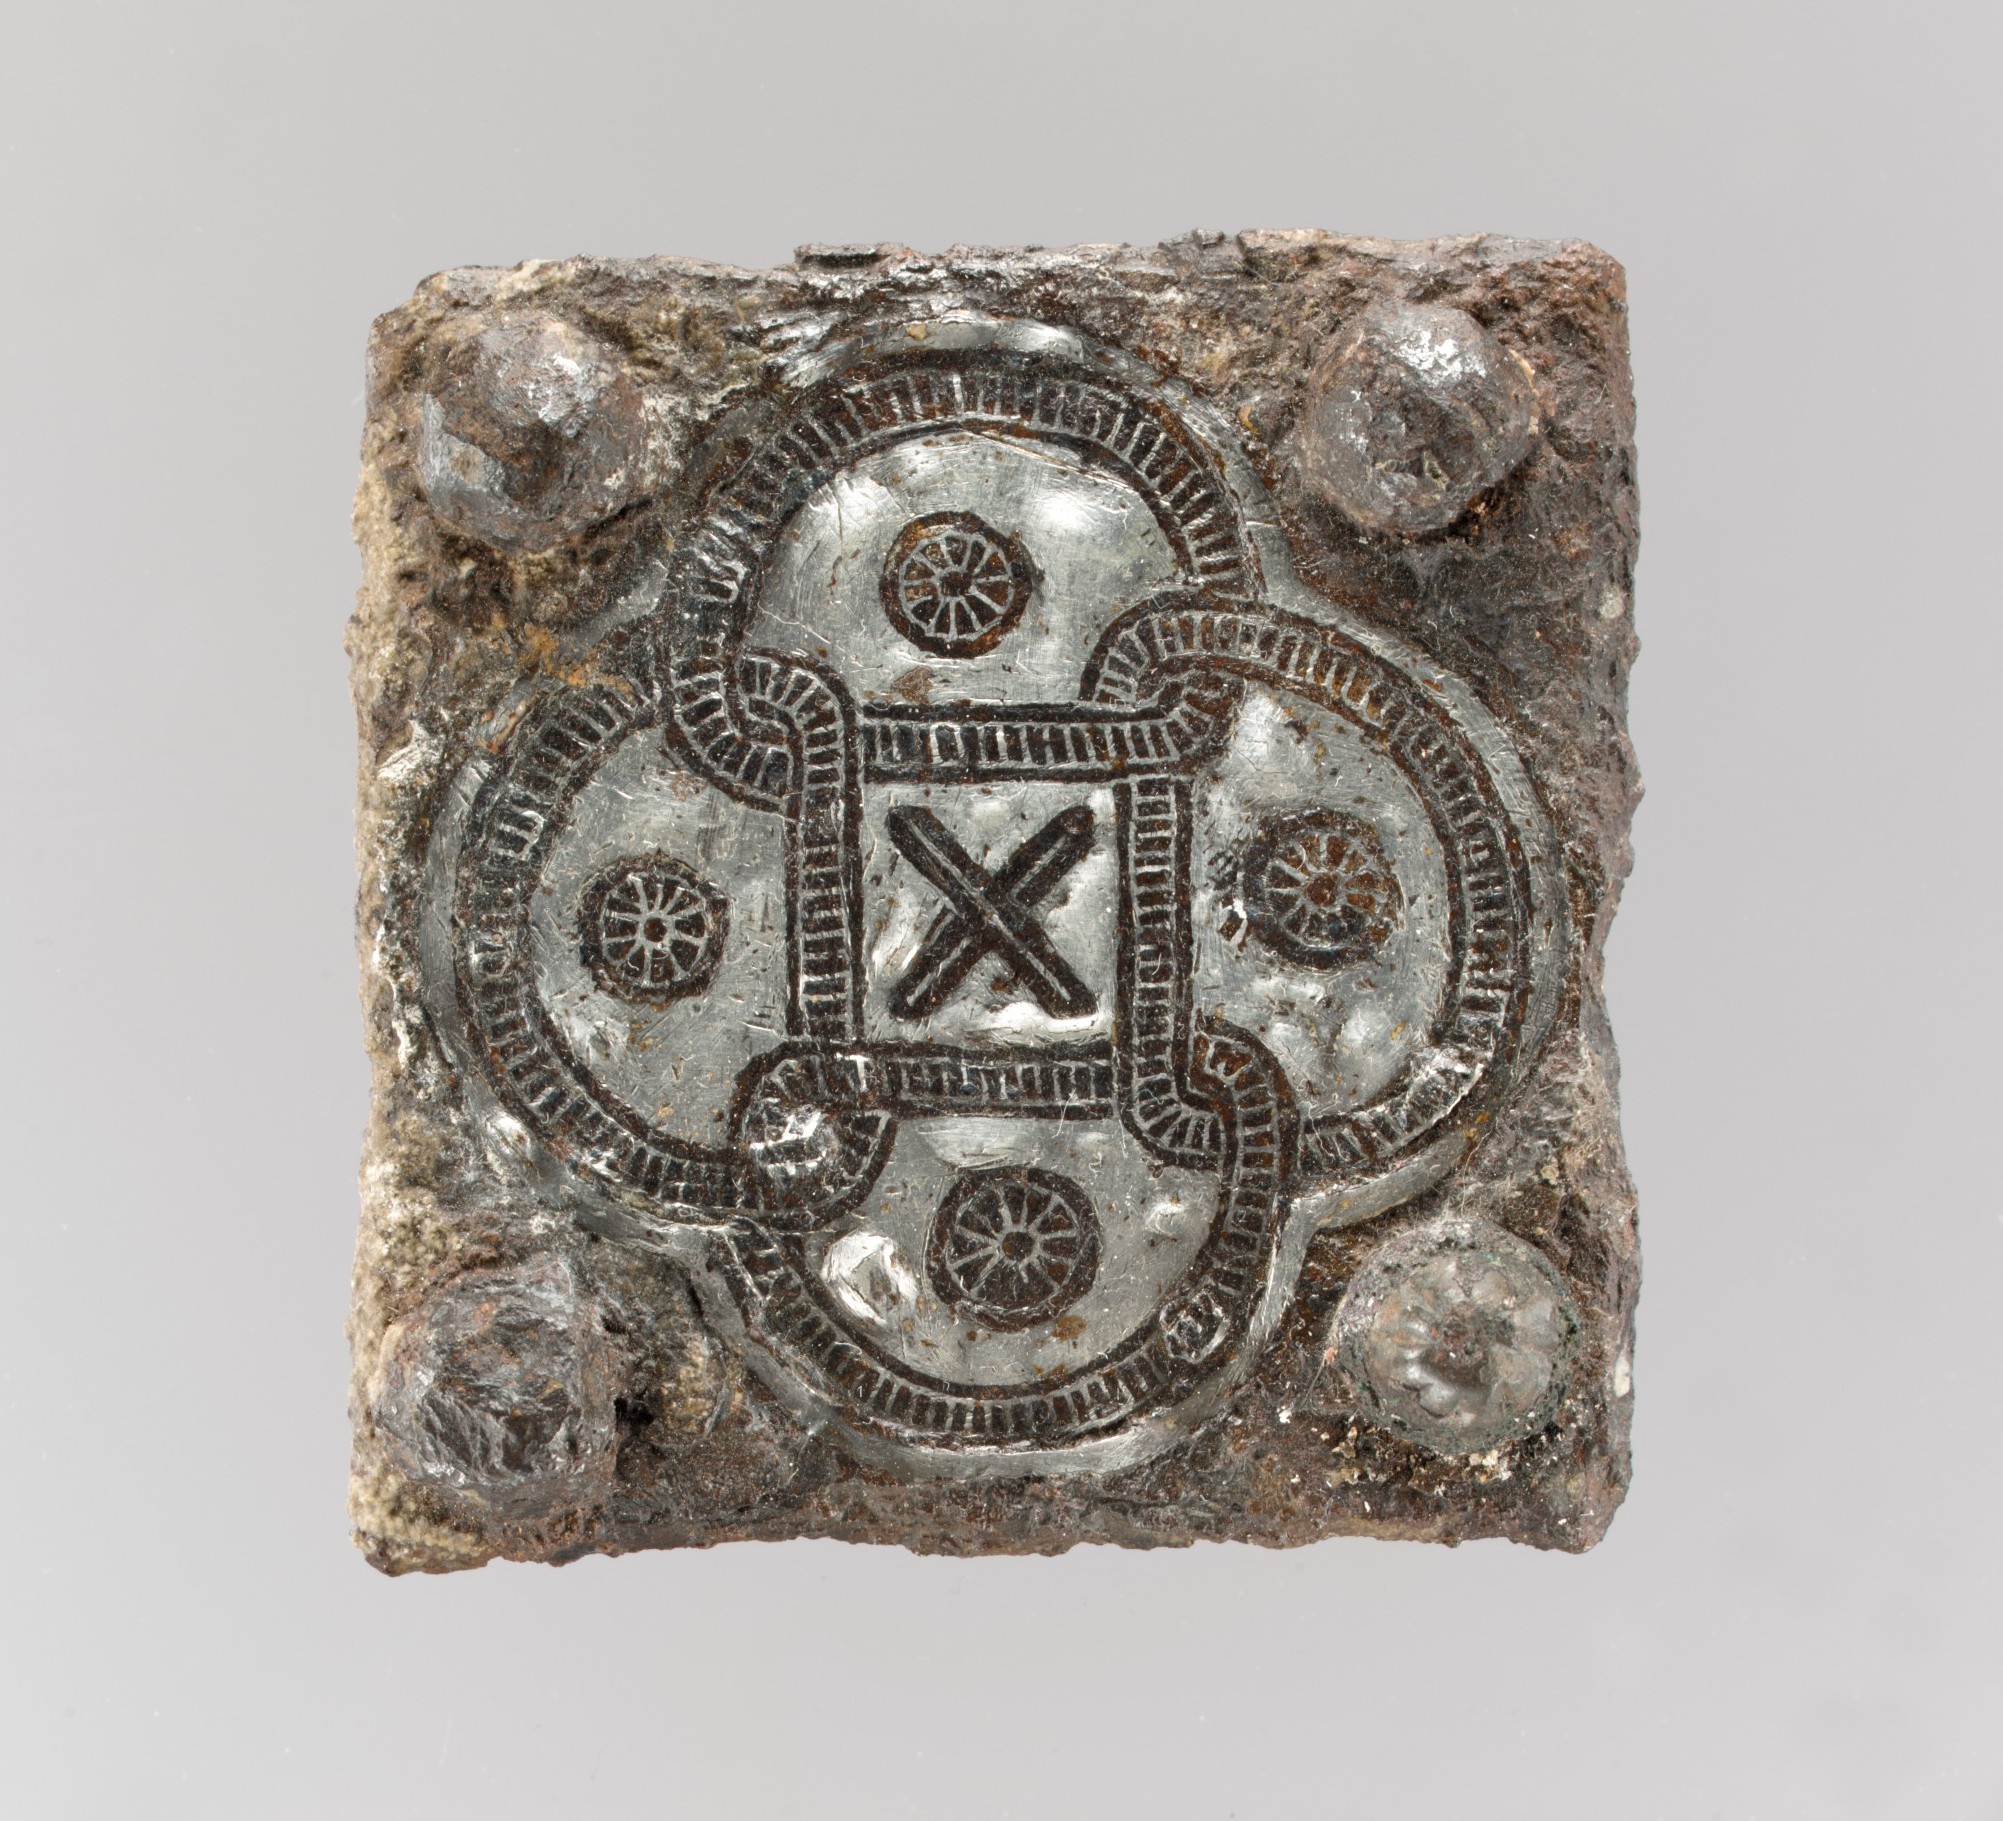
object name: belt plate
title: Back Plate from a Belt Buckle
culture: frankish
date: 601-700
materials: copper alloy, iron, silver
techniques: inlay